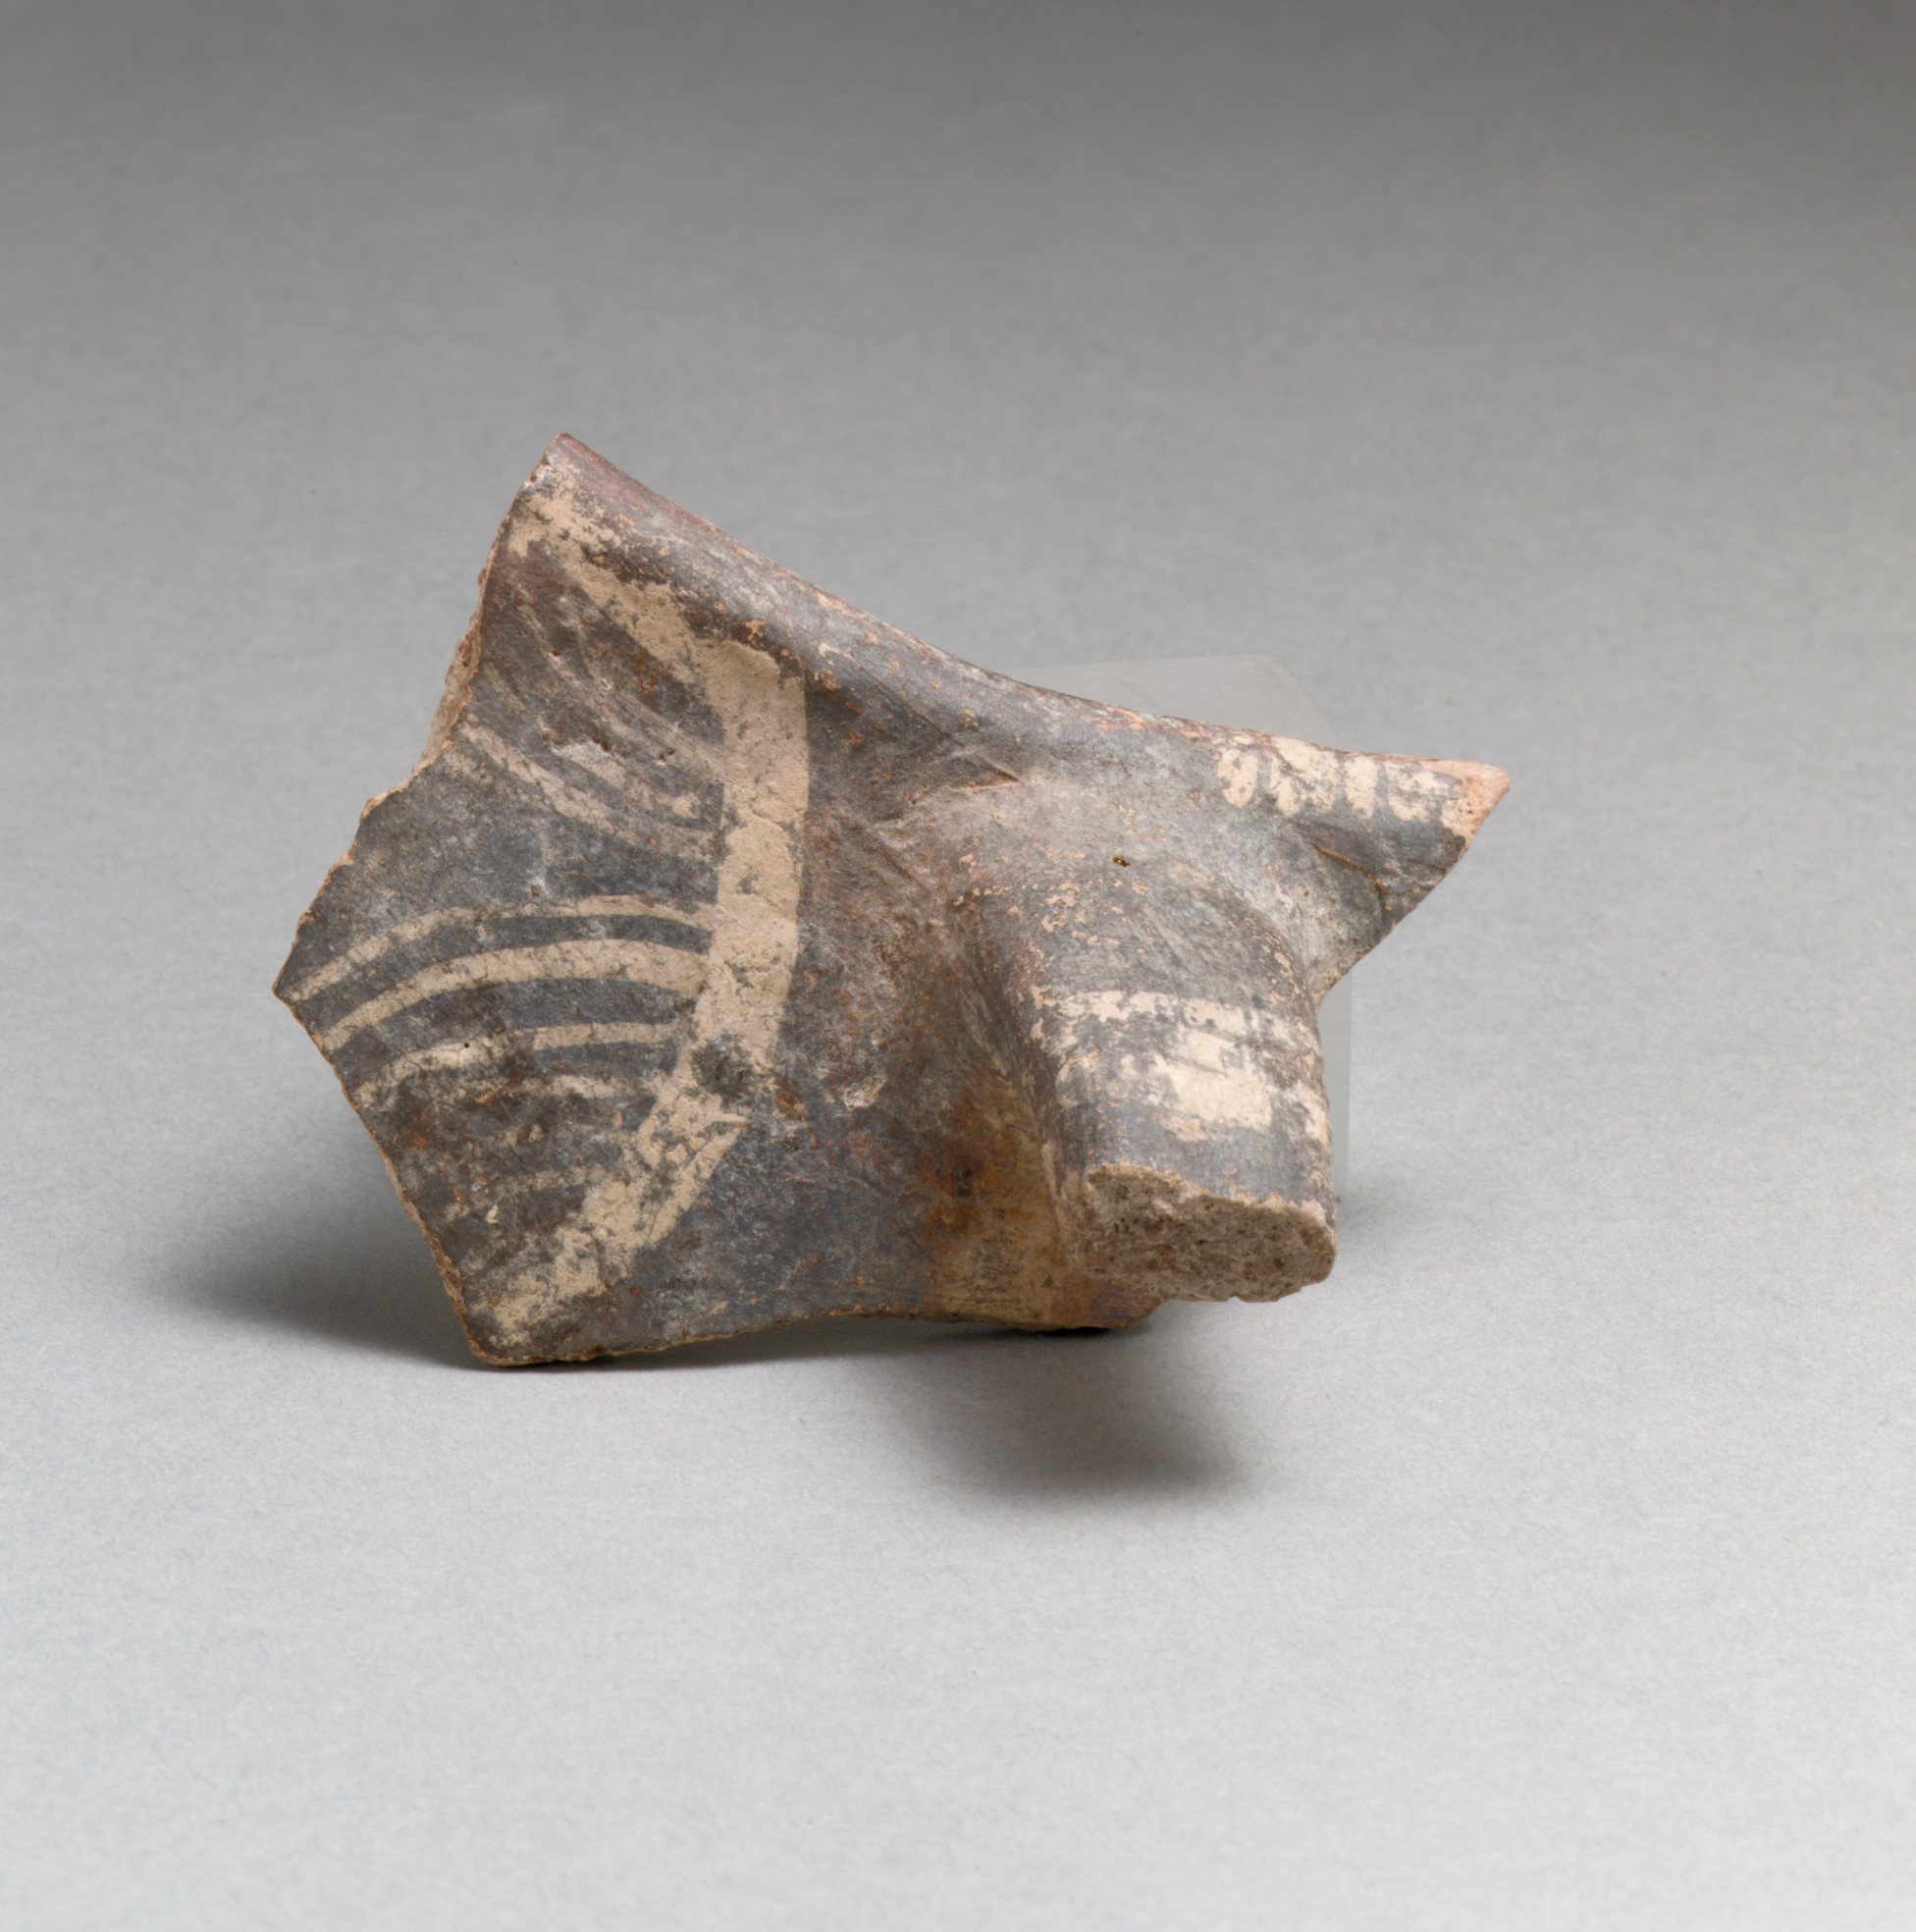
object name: vase fragment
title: Terracotta rim and handle fragment from a jug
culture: minoan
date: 2300-2100 BCE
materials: terracotta